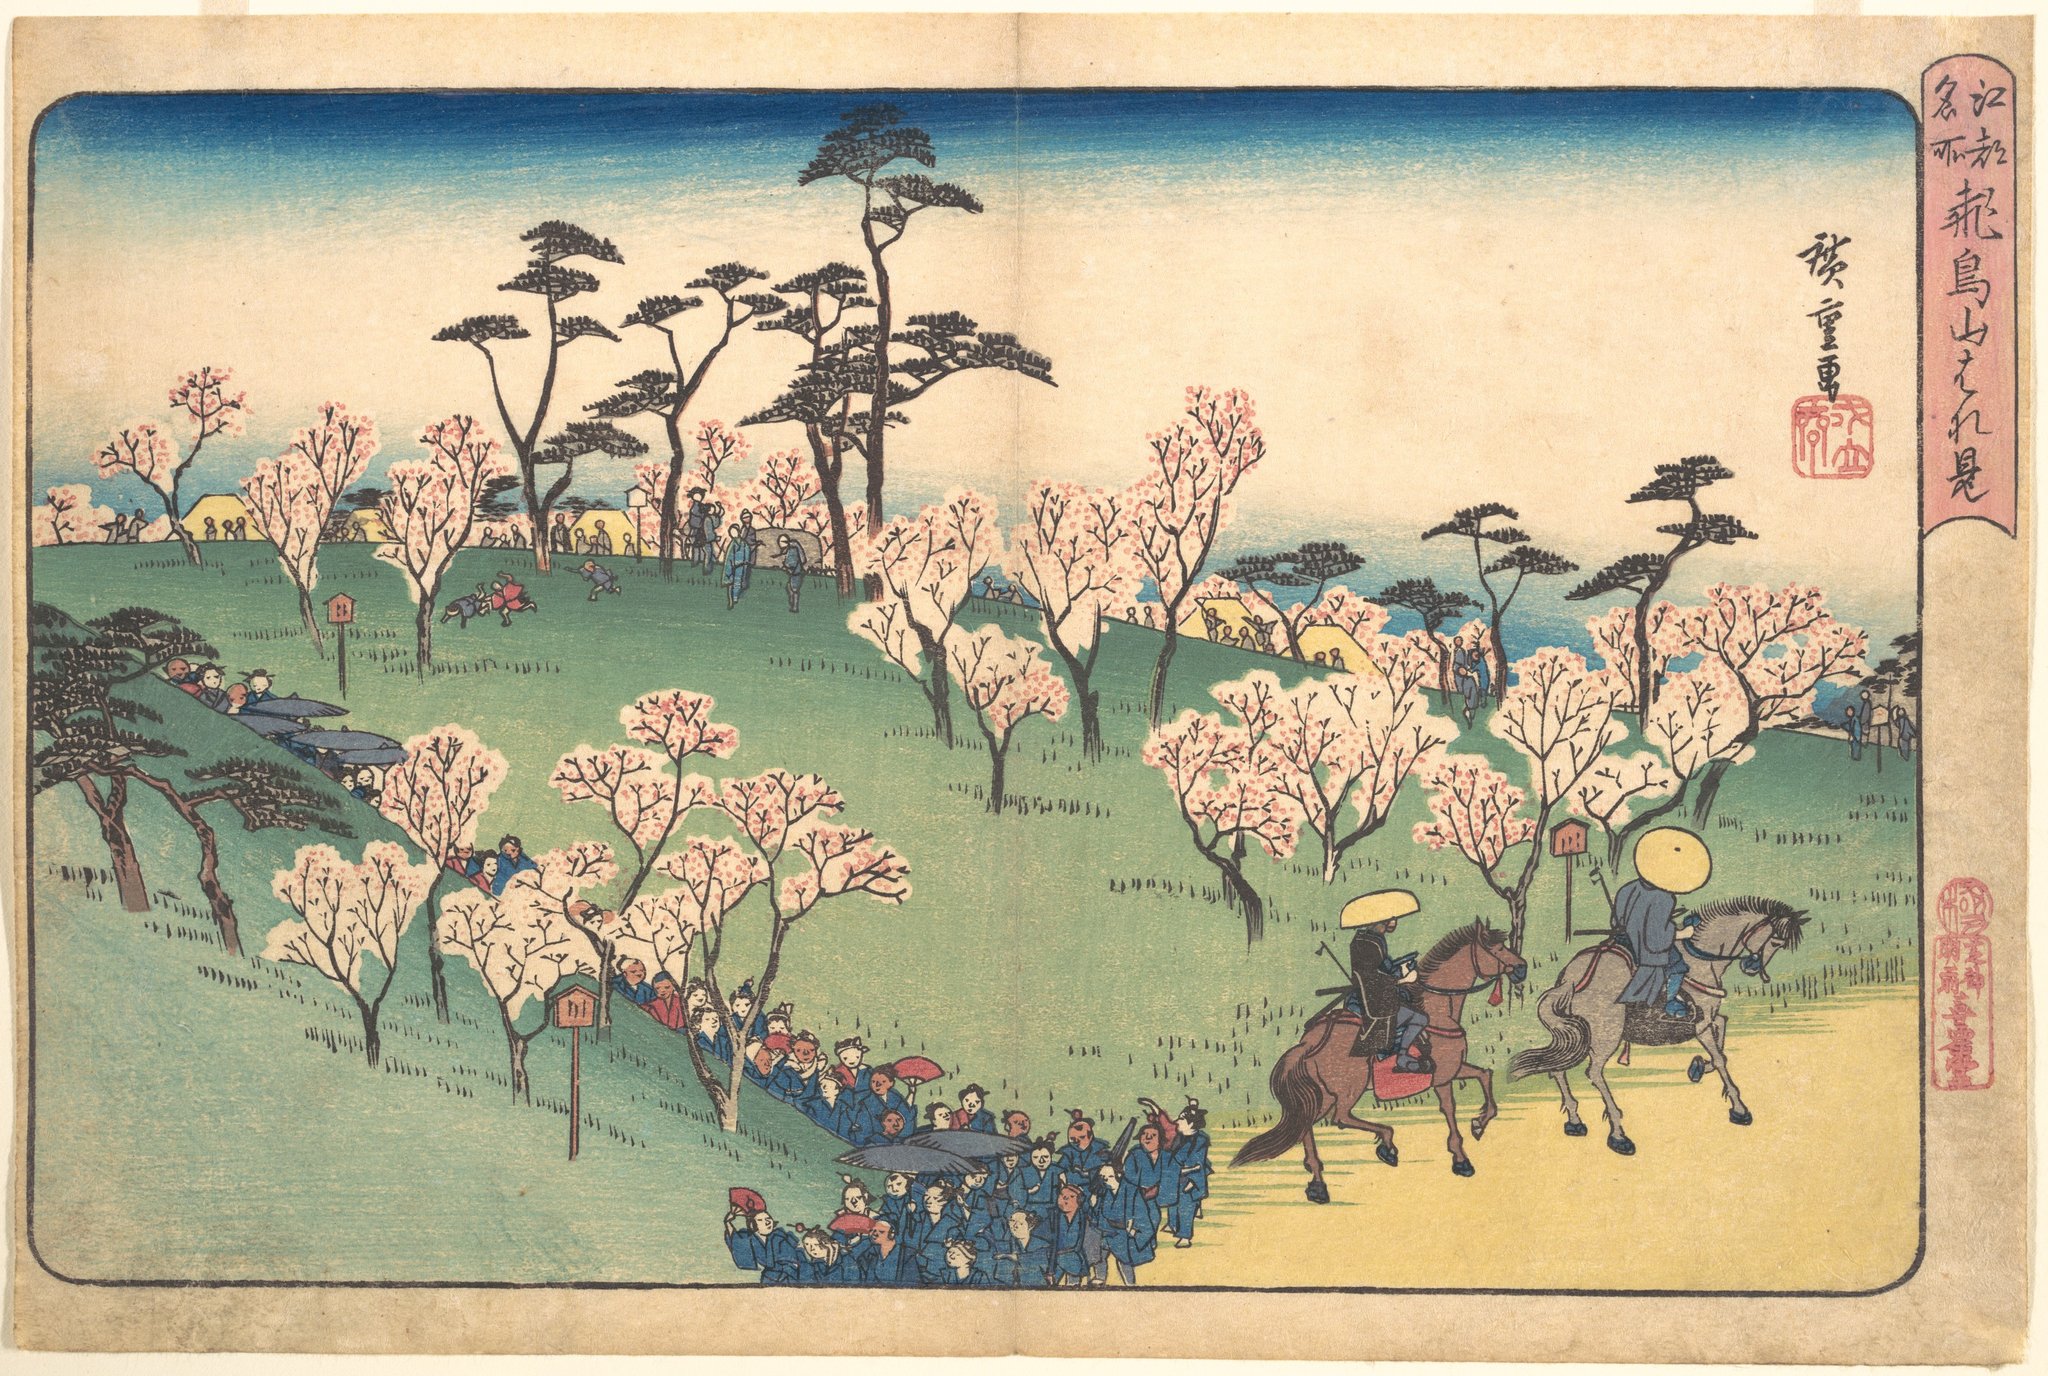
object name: print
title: Asukayama Hanami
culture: japanese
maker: utagawa hiroshige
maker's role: artist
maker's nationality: japanese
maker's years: 1797-1858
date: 1615-1868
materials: ink, paper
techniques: woodblock print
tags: human figures,parks,horses,trees